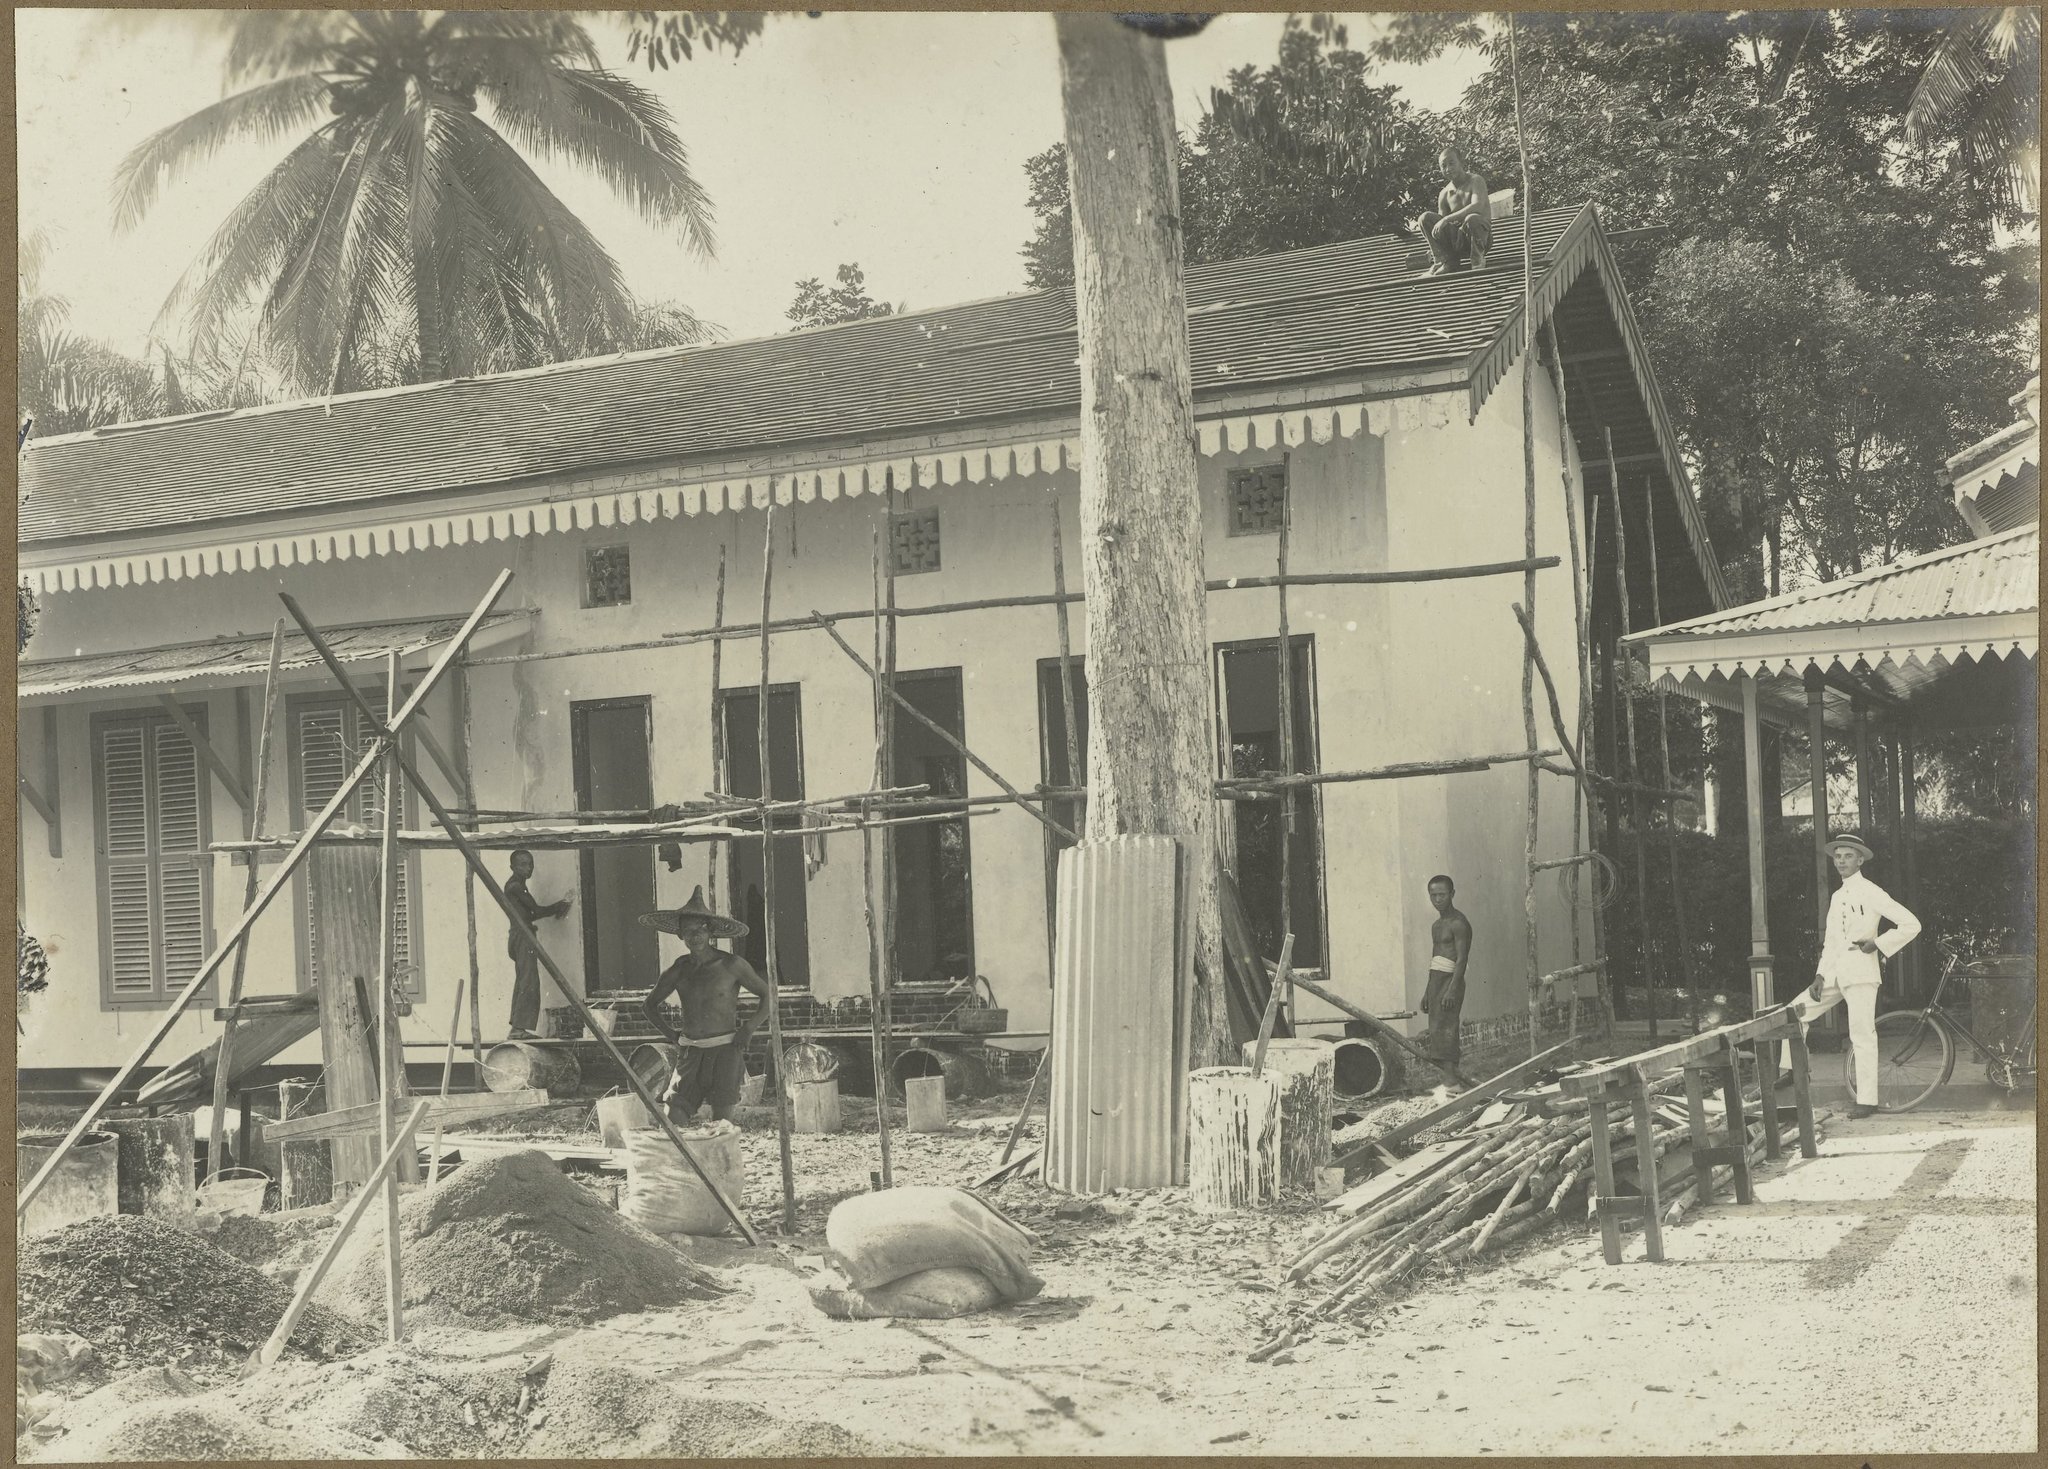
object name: photograph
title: Woonhuis in steigers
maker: Anonymous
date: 1914-1919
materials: photographic support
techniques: gelatin silver print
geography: medan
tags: architect at work, urban housing, making the overground structures (~ building activities), representation of real building (either existing or having existed)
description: Een woonhuis in aanbouw in steigers, met verschillende arbeiders aan het werk, rechts de architect Riphagen. Waarschijnlijk te Medan. Foto in het fotoalbum van het Nederlandse architectenbureau en aannemersbedrijf Bennink en Riphagen te Medan in de jaren ca. 1914-1919.